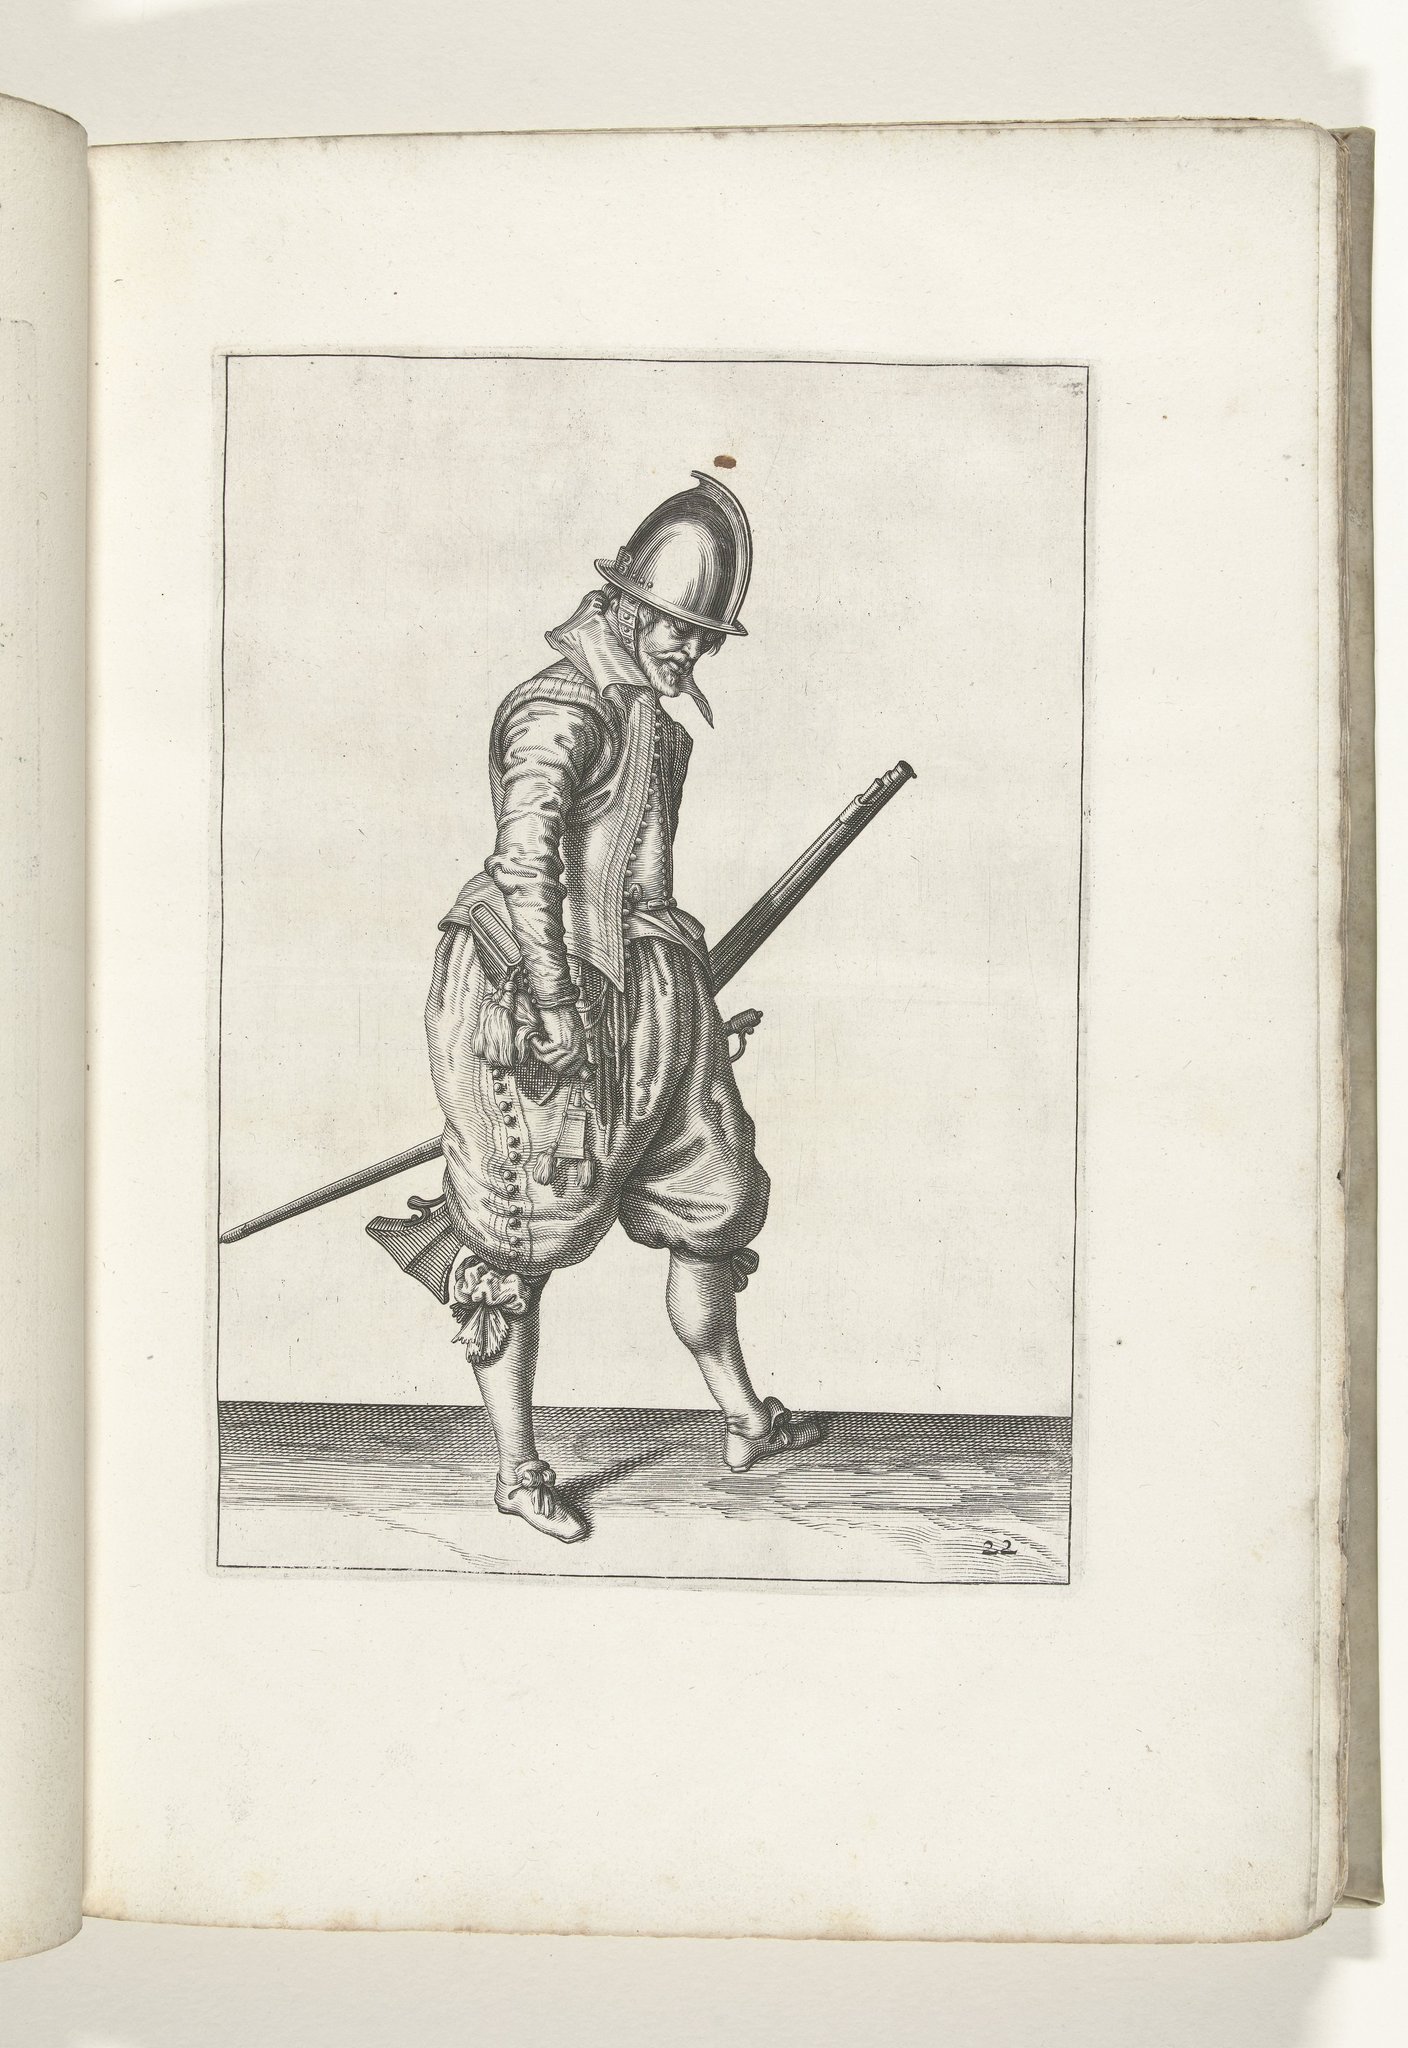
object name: print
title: Soldaat met een roer die zijn kruithoorn opent (nr. 22), ca. 1600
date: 1597-1607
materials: paper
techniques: engraving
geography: northern netherlands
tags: the hague, maurice (prince of orange), handling of weapons ~ military training, weapons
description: Een soldaat, ten voeten uit, naar rechts, die met zijn linkerhand bij zijn linkerdijbeen een roer (een bepaald type vuurwapen) vasthoudt, de loop schuin omhoog wijzend (nr. 22), ca. 1600. Met zijn rechterhand opent hij een kruithoorn. Plaat 21 in de instructies voor het hanteren van de roer: Corte onderwysinghe op de figuerliicke afbeeldinghe, belanghende t'rechte ghebruyck des Roers. Onderdeel van de illustraties in: J. de Gheyn, Wapenhandelinghe van Roers Musquetten ende spiessen, 's-Gravenhage, 1607. Krijgswezen rond 1600.